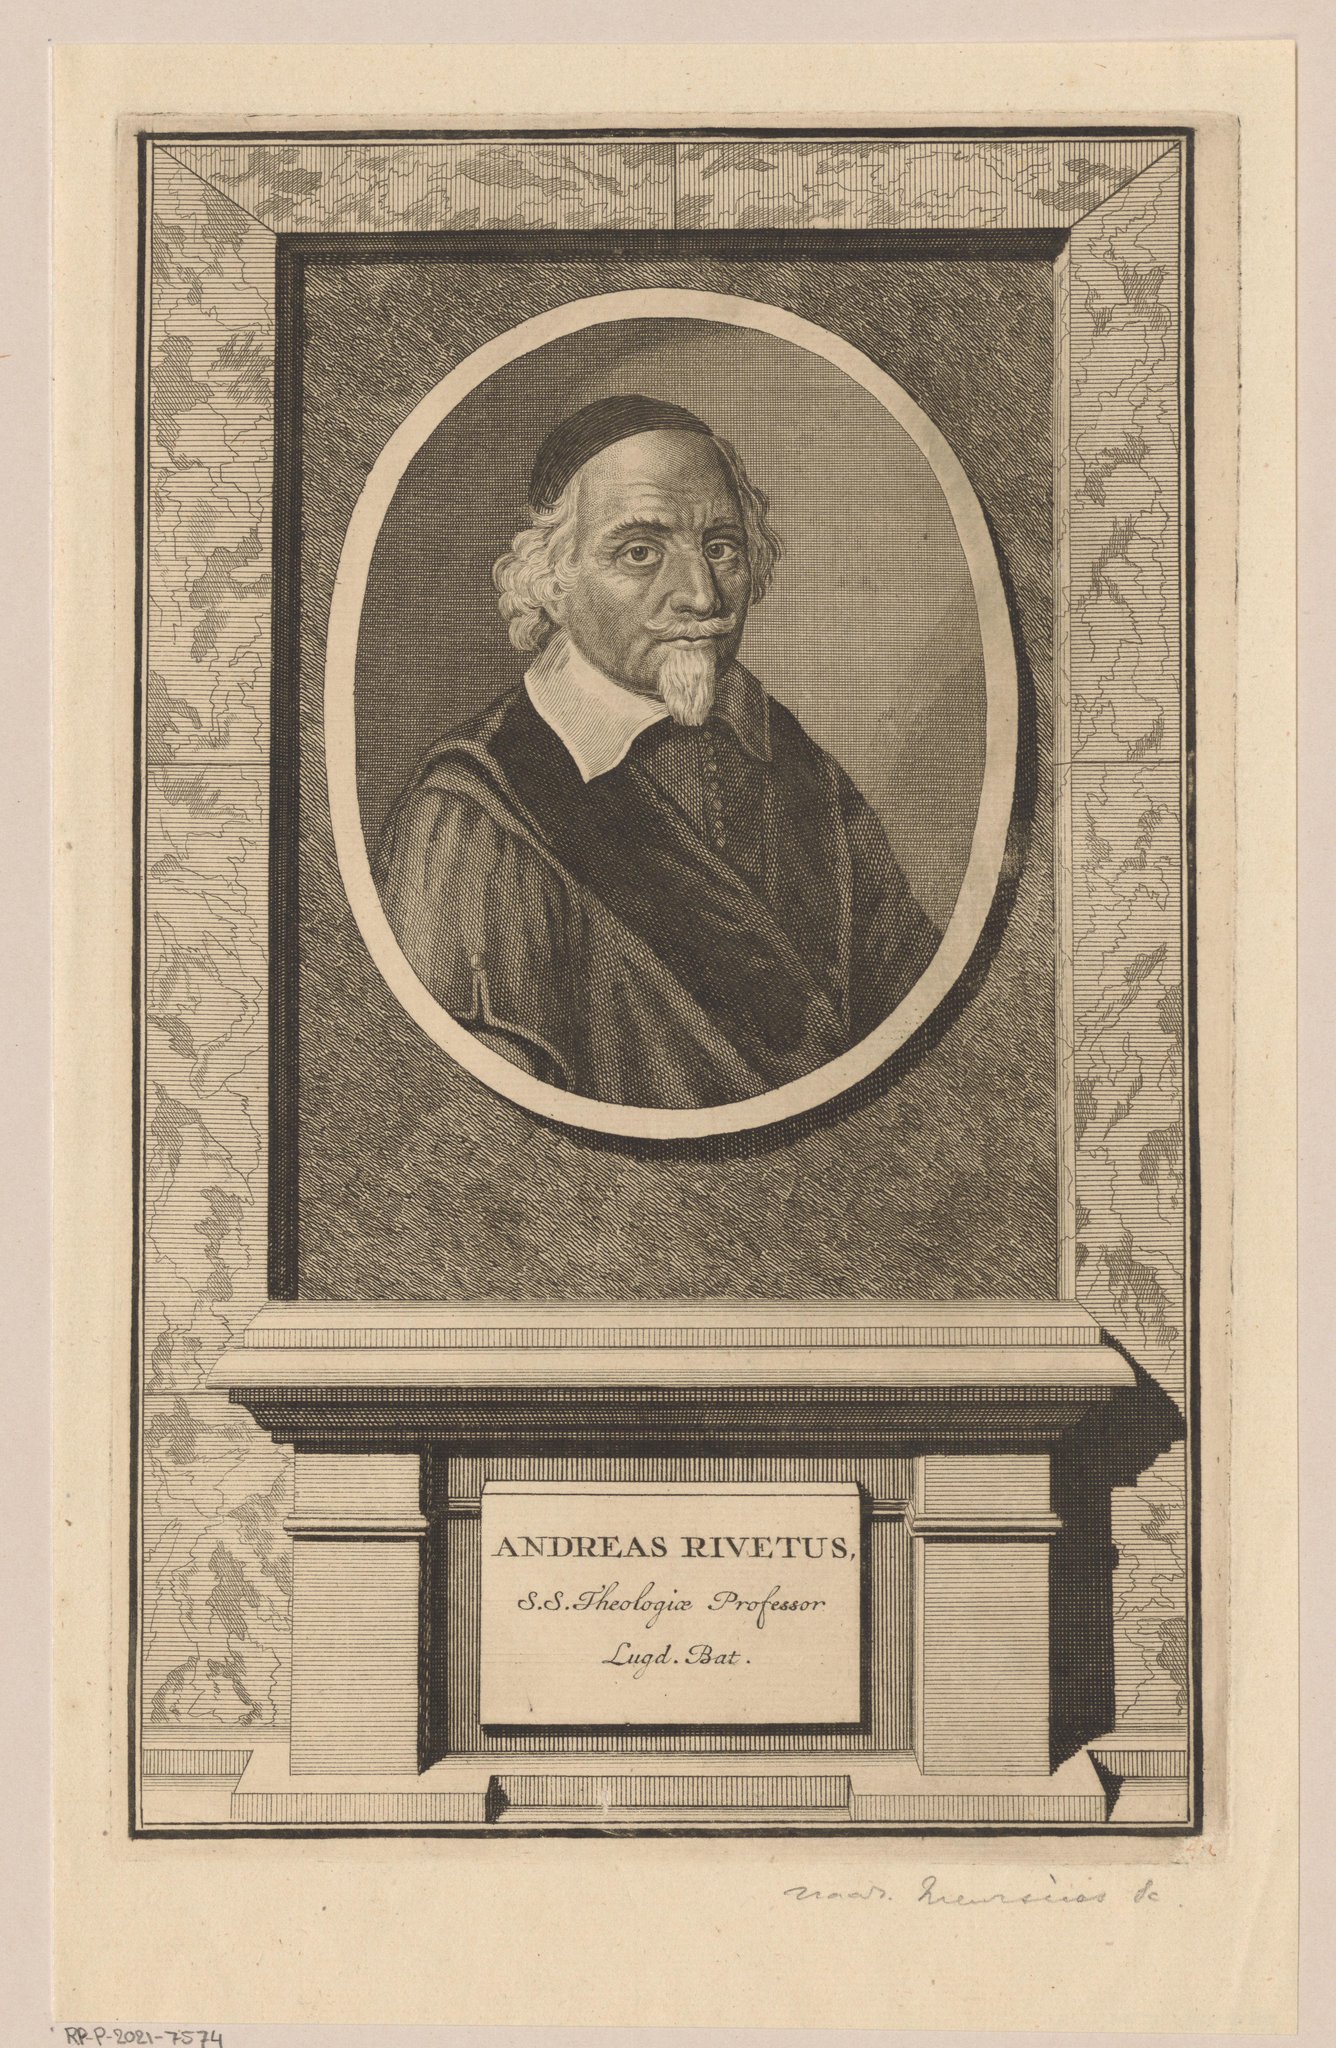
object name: print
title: Portret van André Rivet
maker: Anonymous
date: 1720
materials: paper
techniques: engraving, etching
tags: andré rivet, historical persons, professor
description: Prent mogelijk uit: Fundatoris, curatorum et professorum celeberrimorum (...). Leiden: Pieter van der Aa I, [1720].